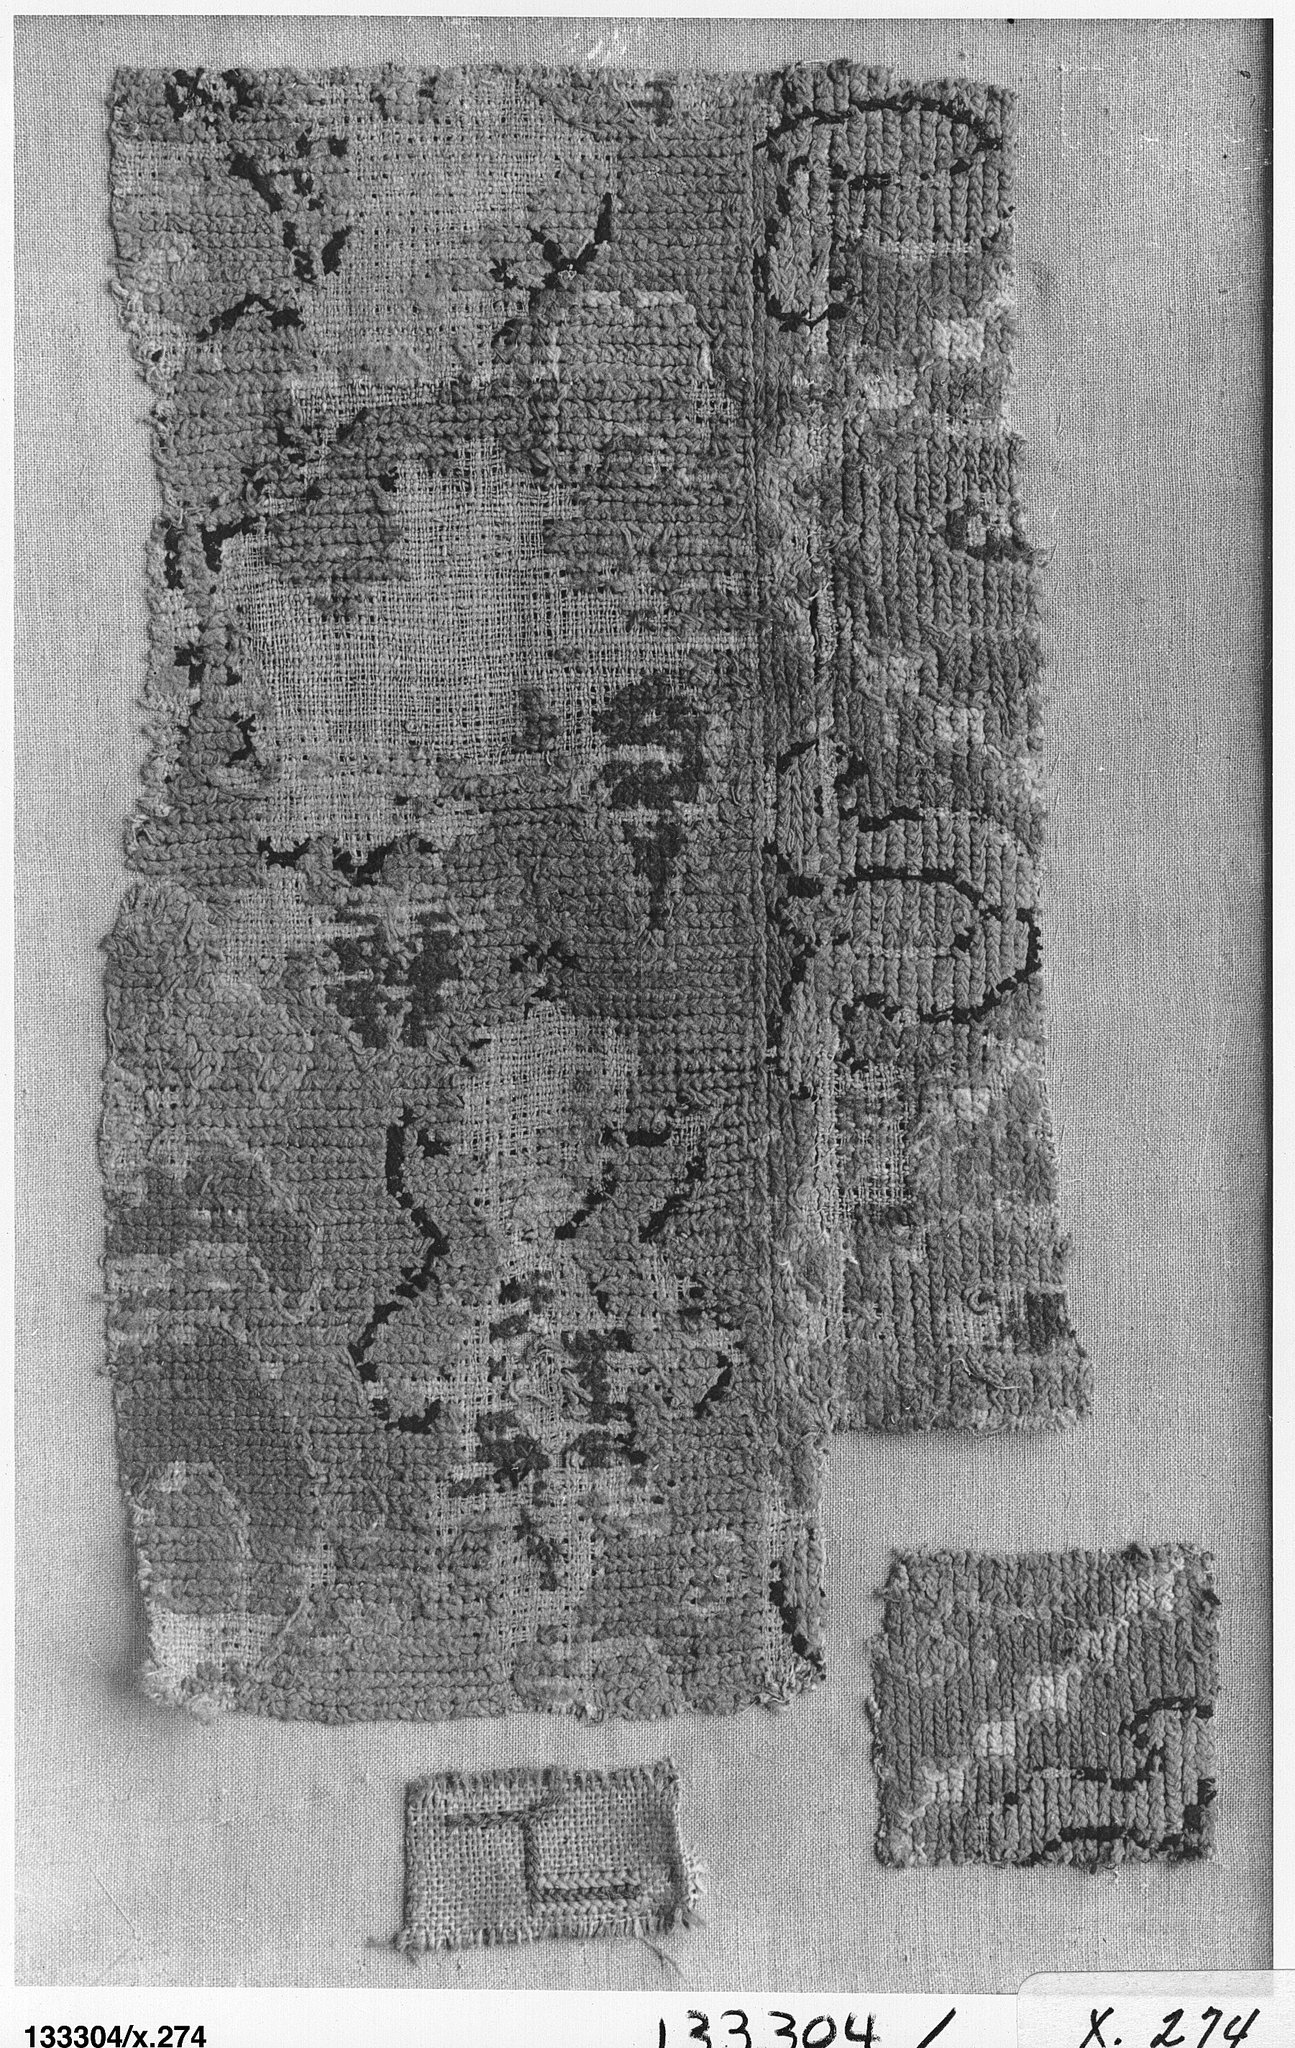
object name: fragment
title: Rug fragments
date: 1501-1600